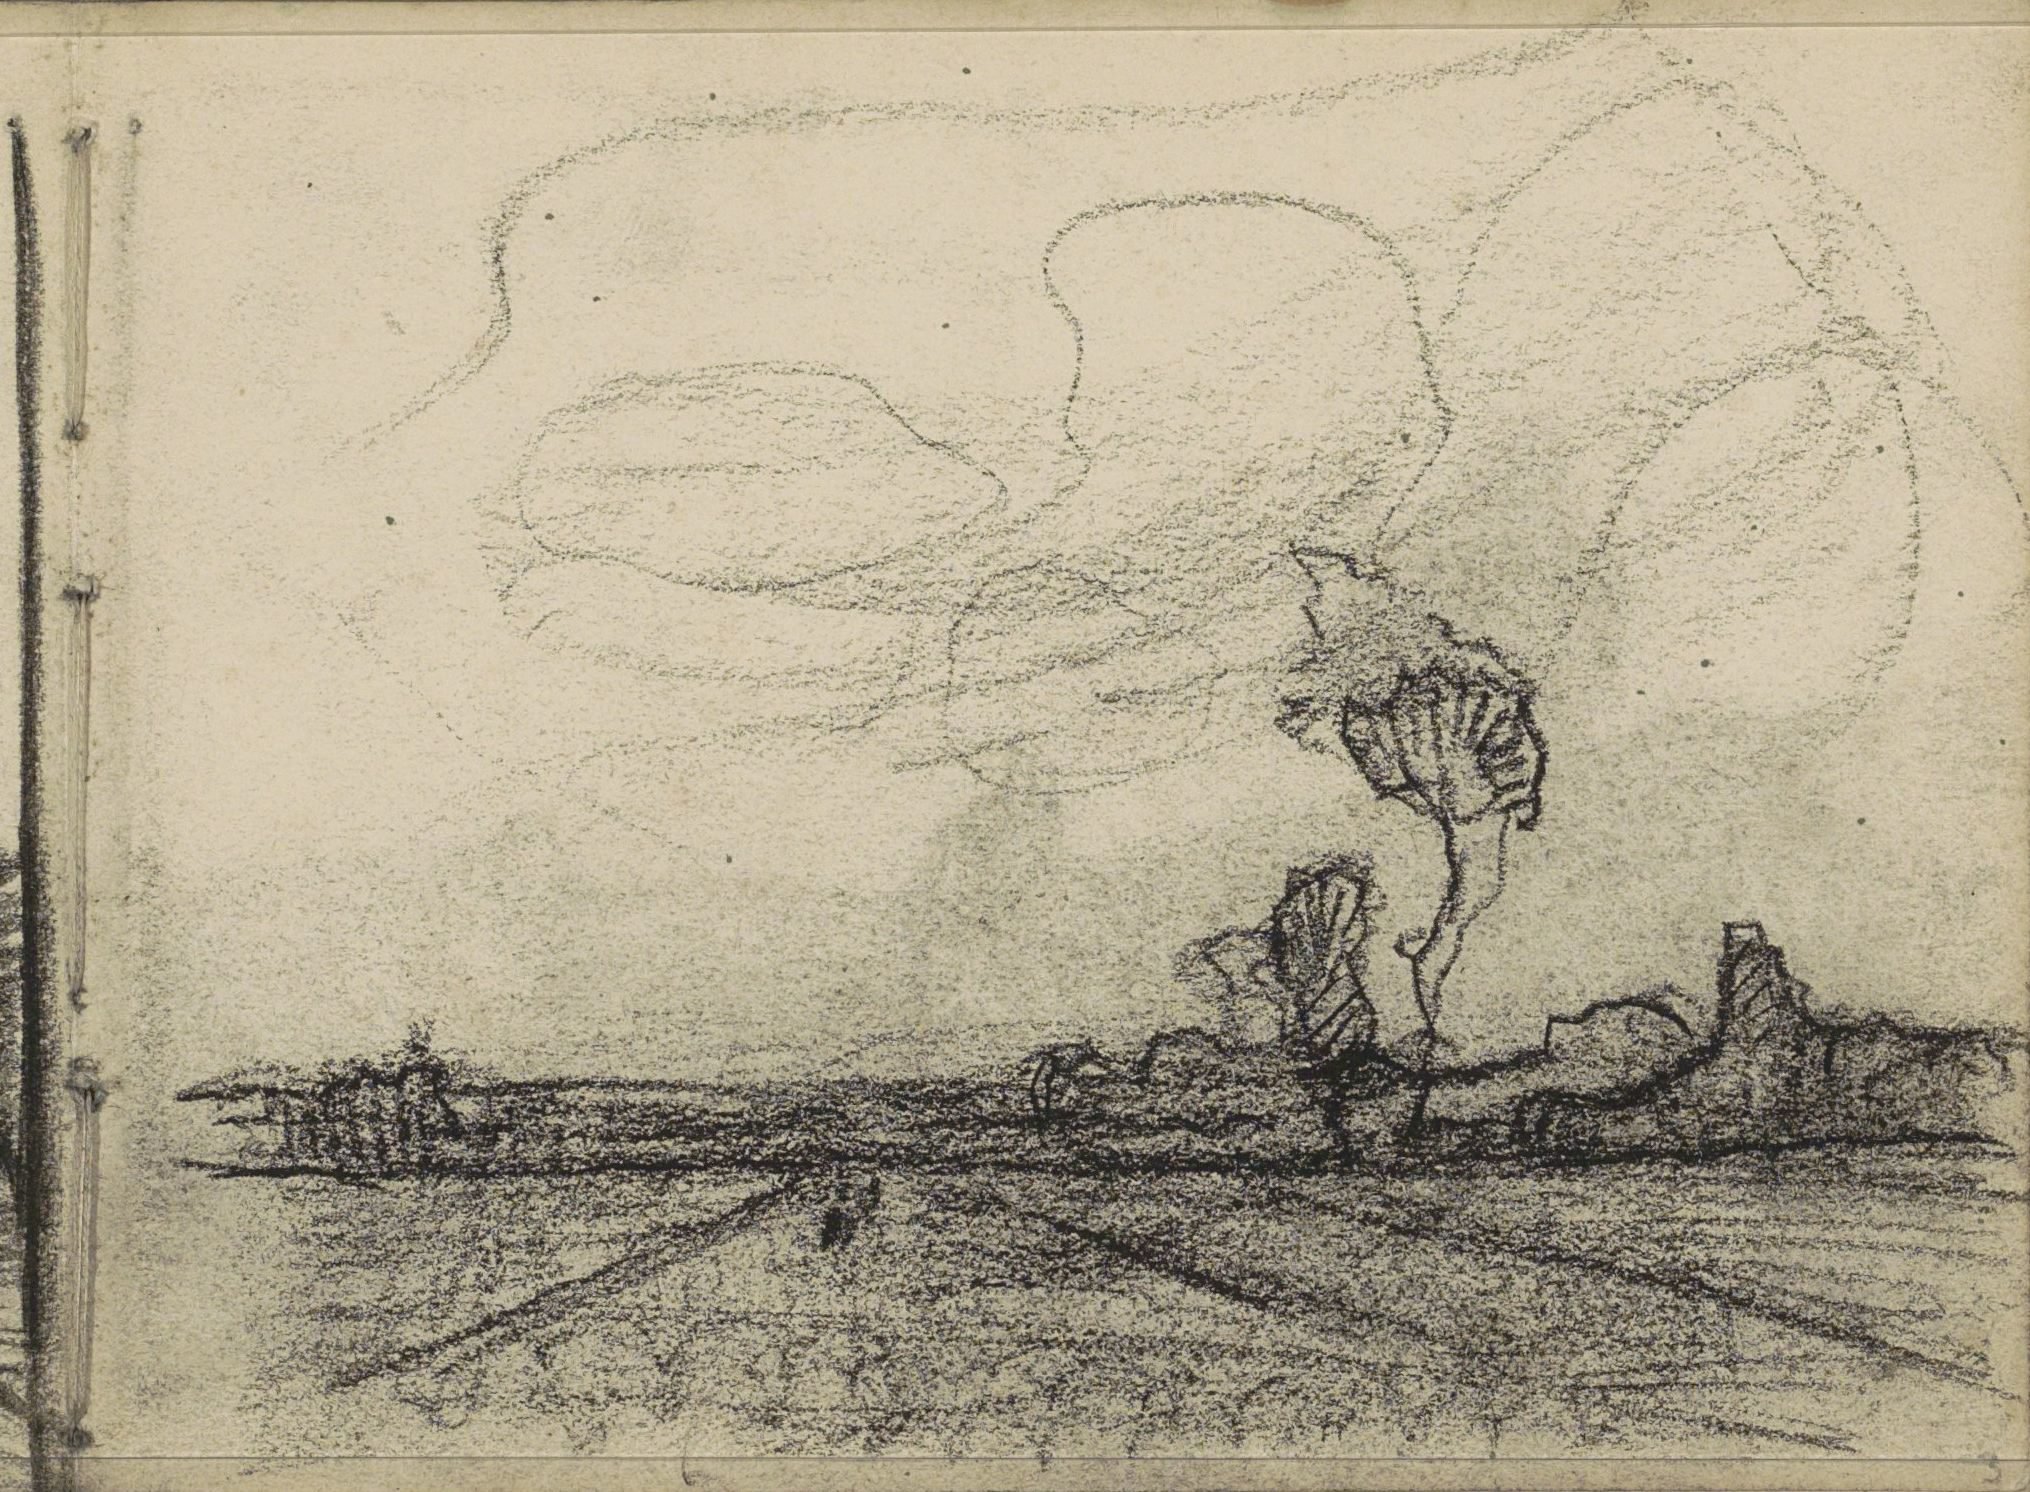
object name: sketchbook leaf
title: Landschap met bomen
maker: hermannus adrianus van oosterzee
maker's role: draughtsman, painter, print maker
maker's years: 1863-1933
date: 1893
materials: charcoal, paper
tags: landscapes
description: Blad 3 recto uit een schetsboek met 23 bladen.